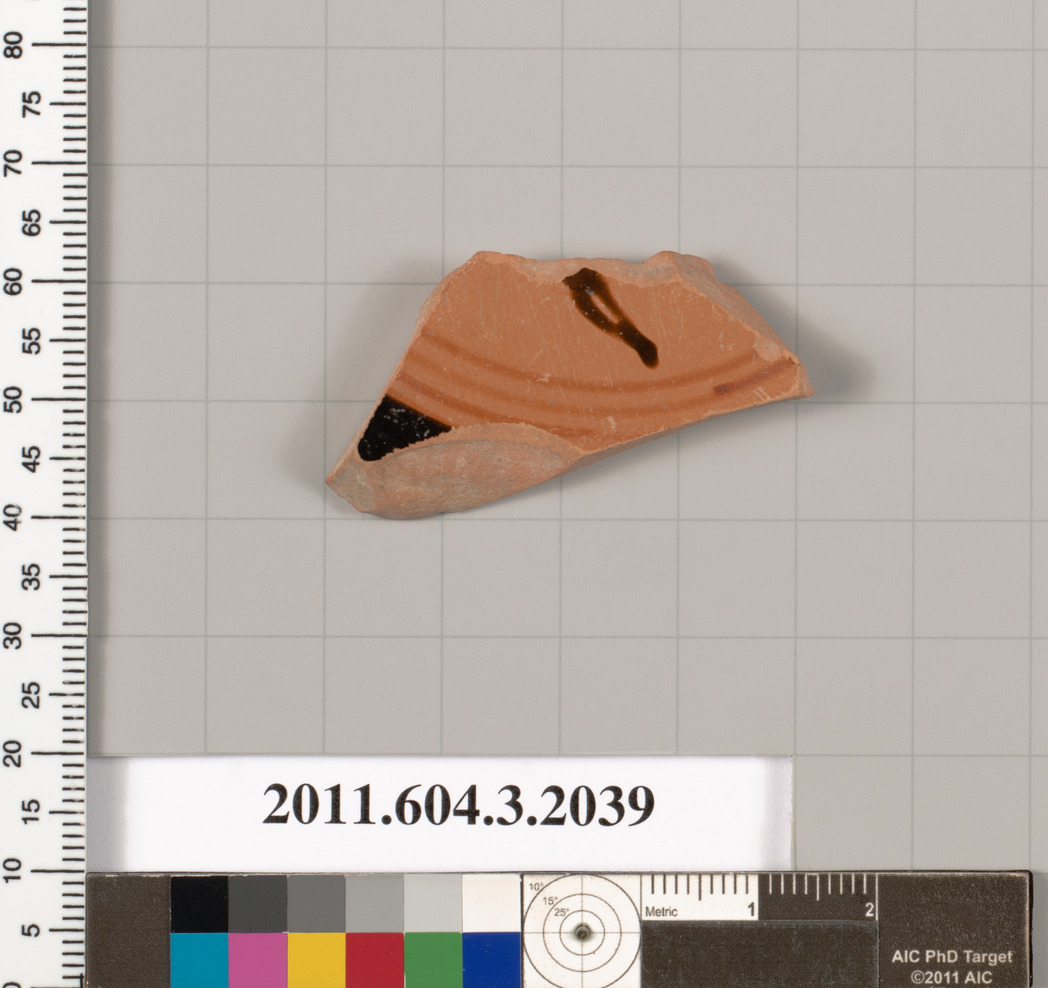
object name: kylix fragment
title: Terracotta fragment of a kylix (drinking cup)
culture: greek, attic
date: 500-468 BCE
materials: terracotta